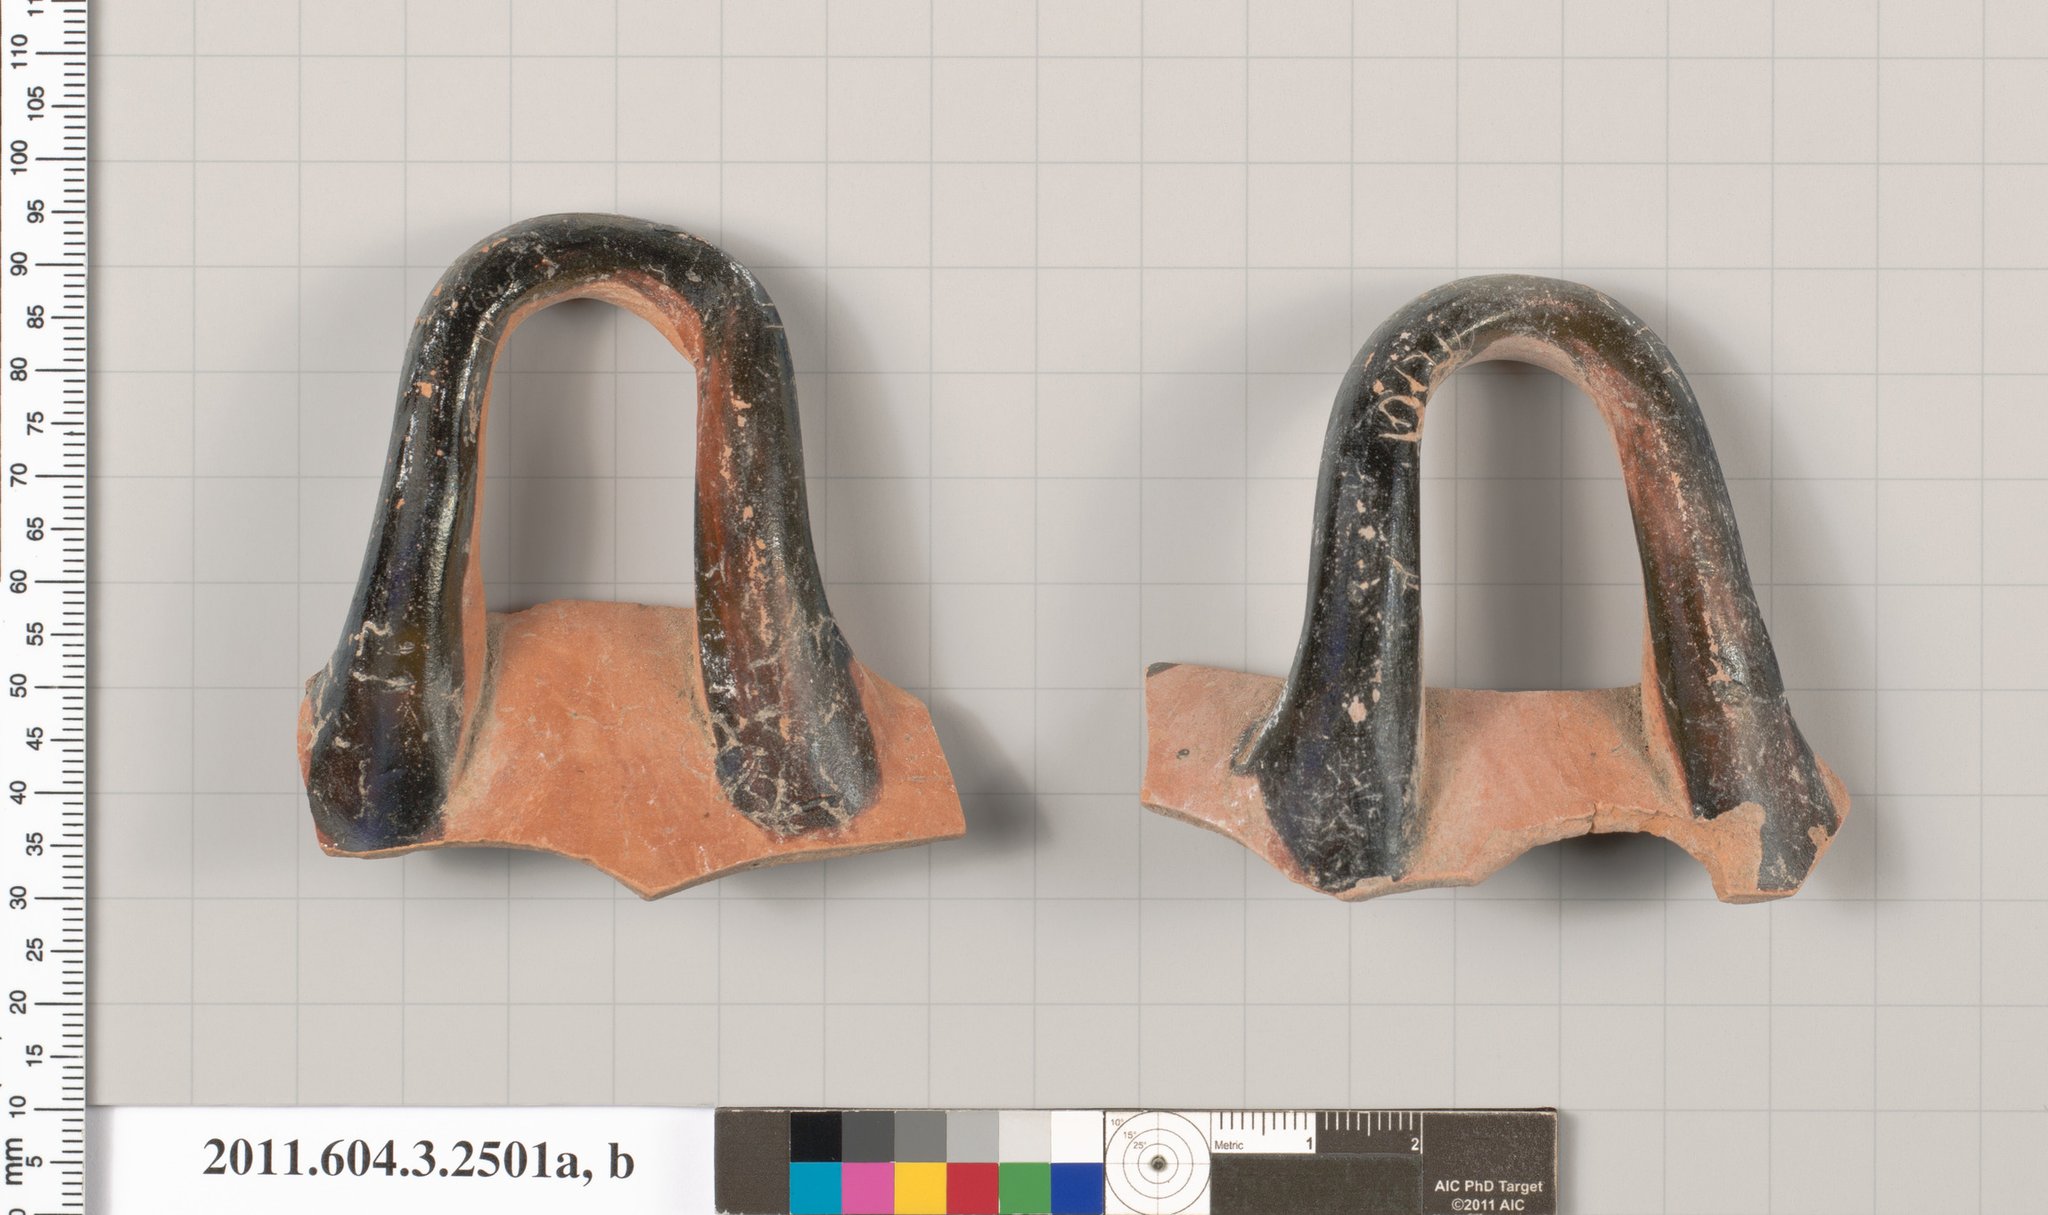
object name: kylix fragment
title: Terracotta fragments of a kylix (drinking cup)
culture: greek, attic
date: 600-401 BCE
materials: terracotta